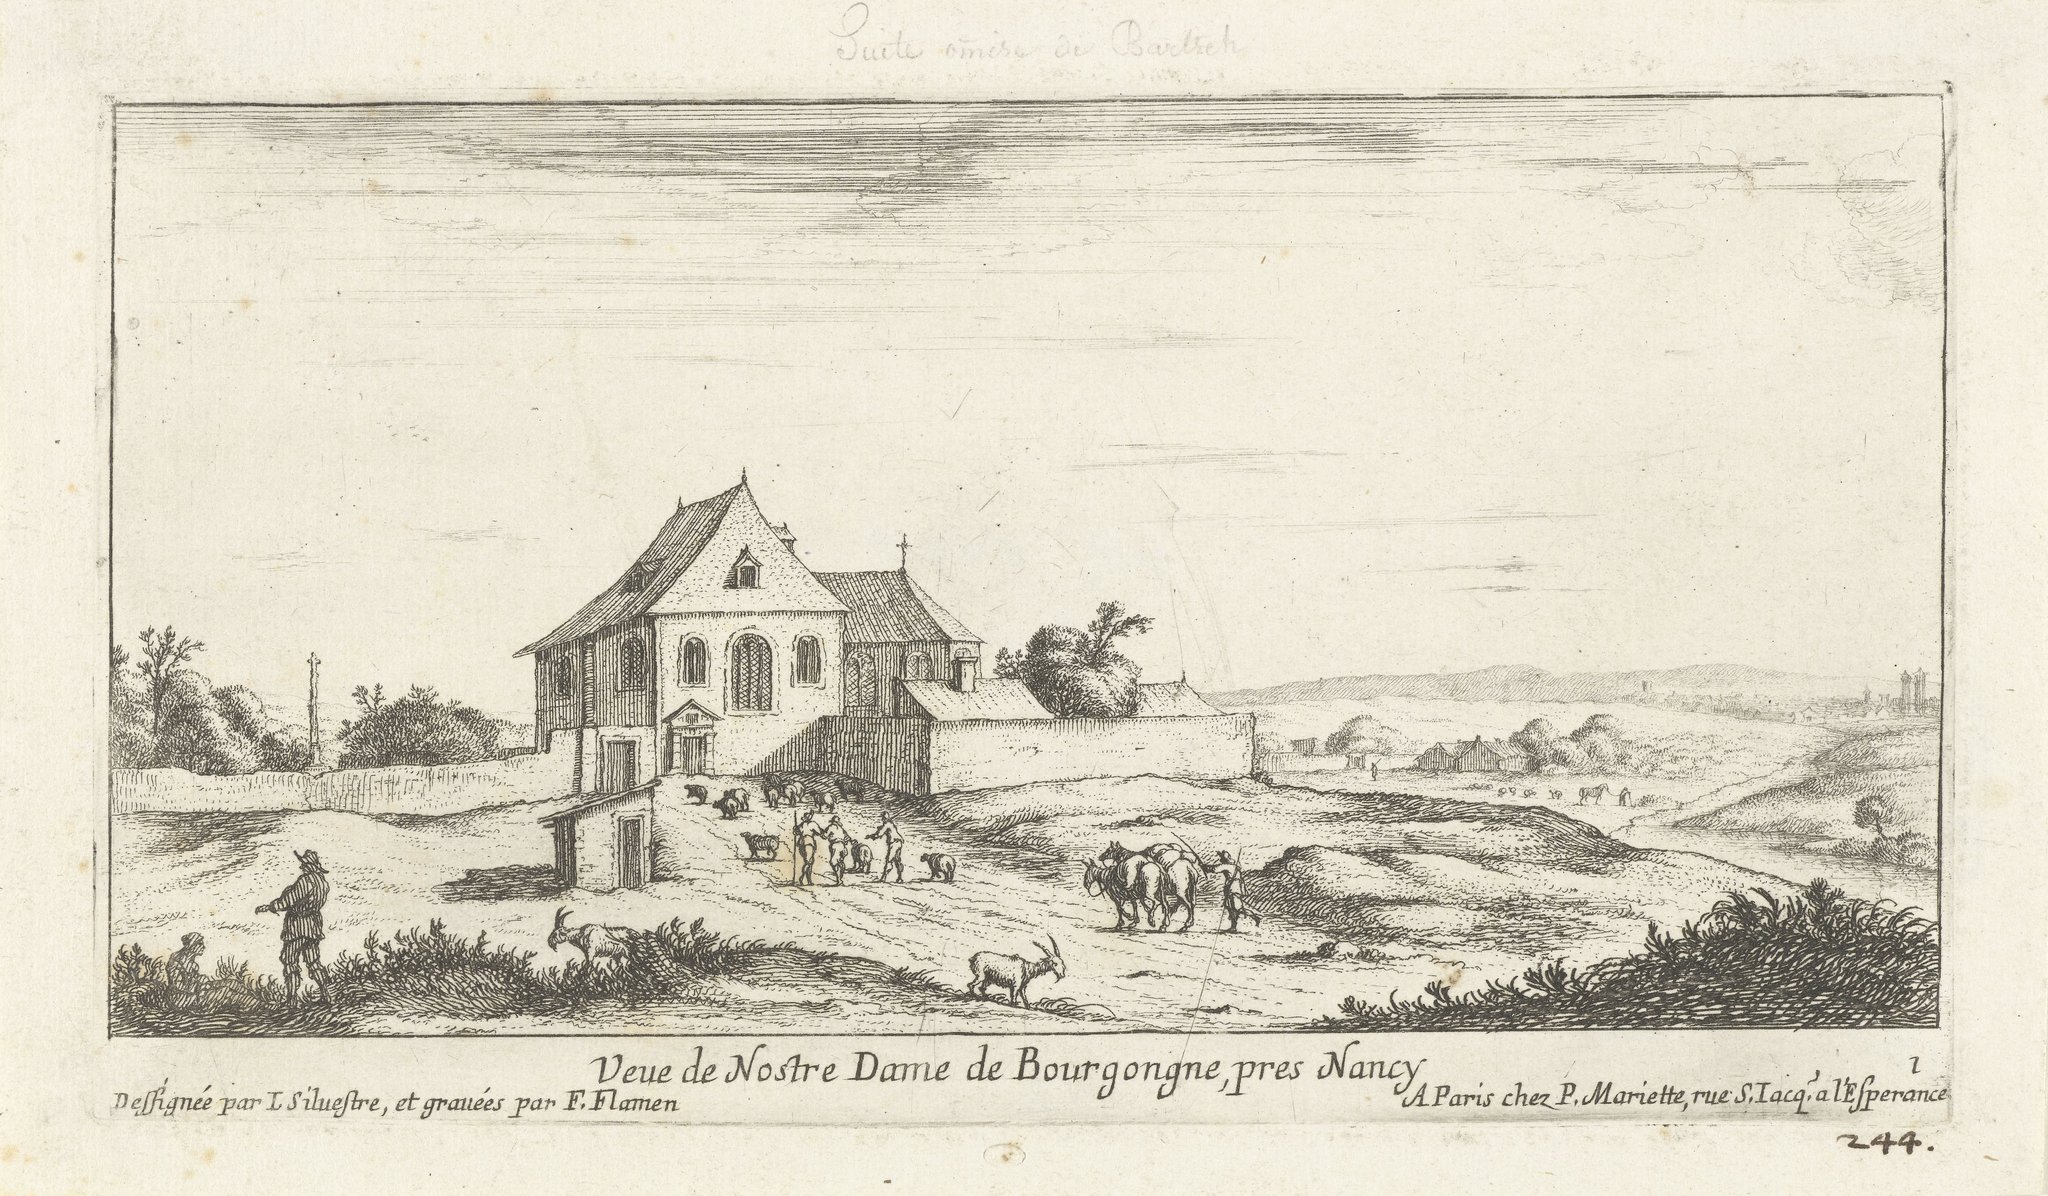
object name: print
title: Veue de Nostre Dame de Bourgonge pres Nancy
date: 1648-1692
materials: paper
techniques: etching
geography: paris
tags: church (exterior)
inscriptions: collector's mark: Lugt 2228, collector's mark: Lugt 2200, collector's mark: Lugt 414, collector's mark: Lugt 2161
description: Gezicht op een kapel in een heuvelachtig landschap. Op het pad naar de kapel enkele herders met hun kudde.